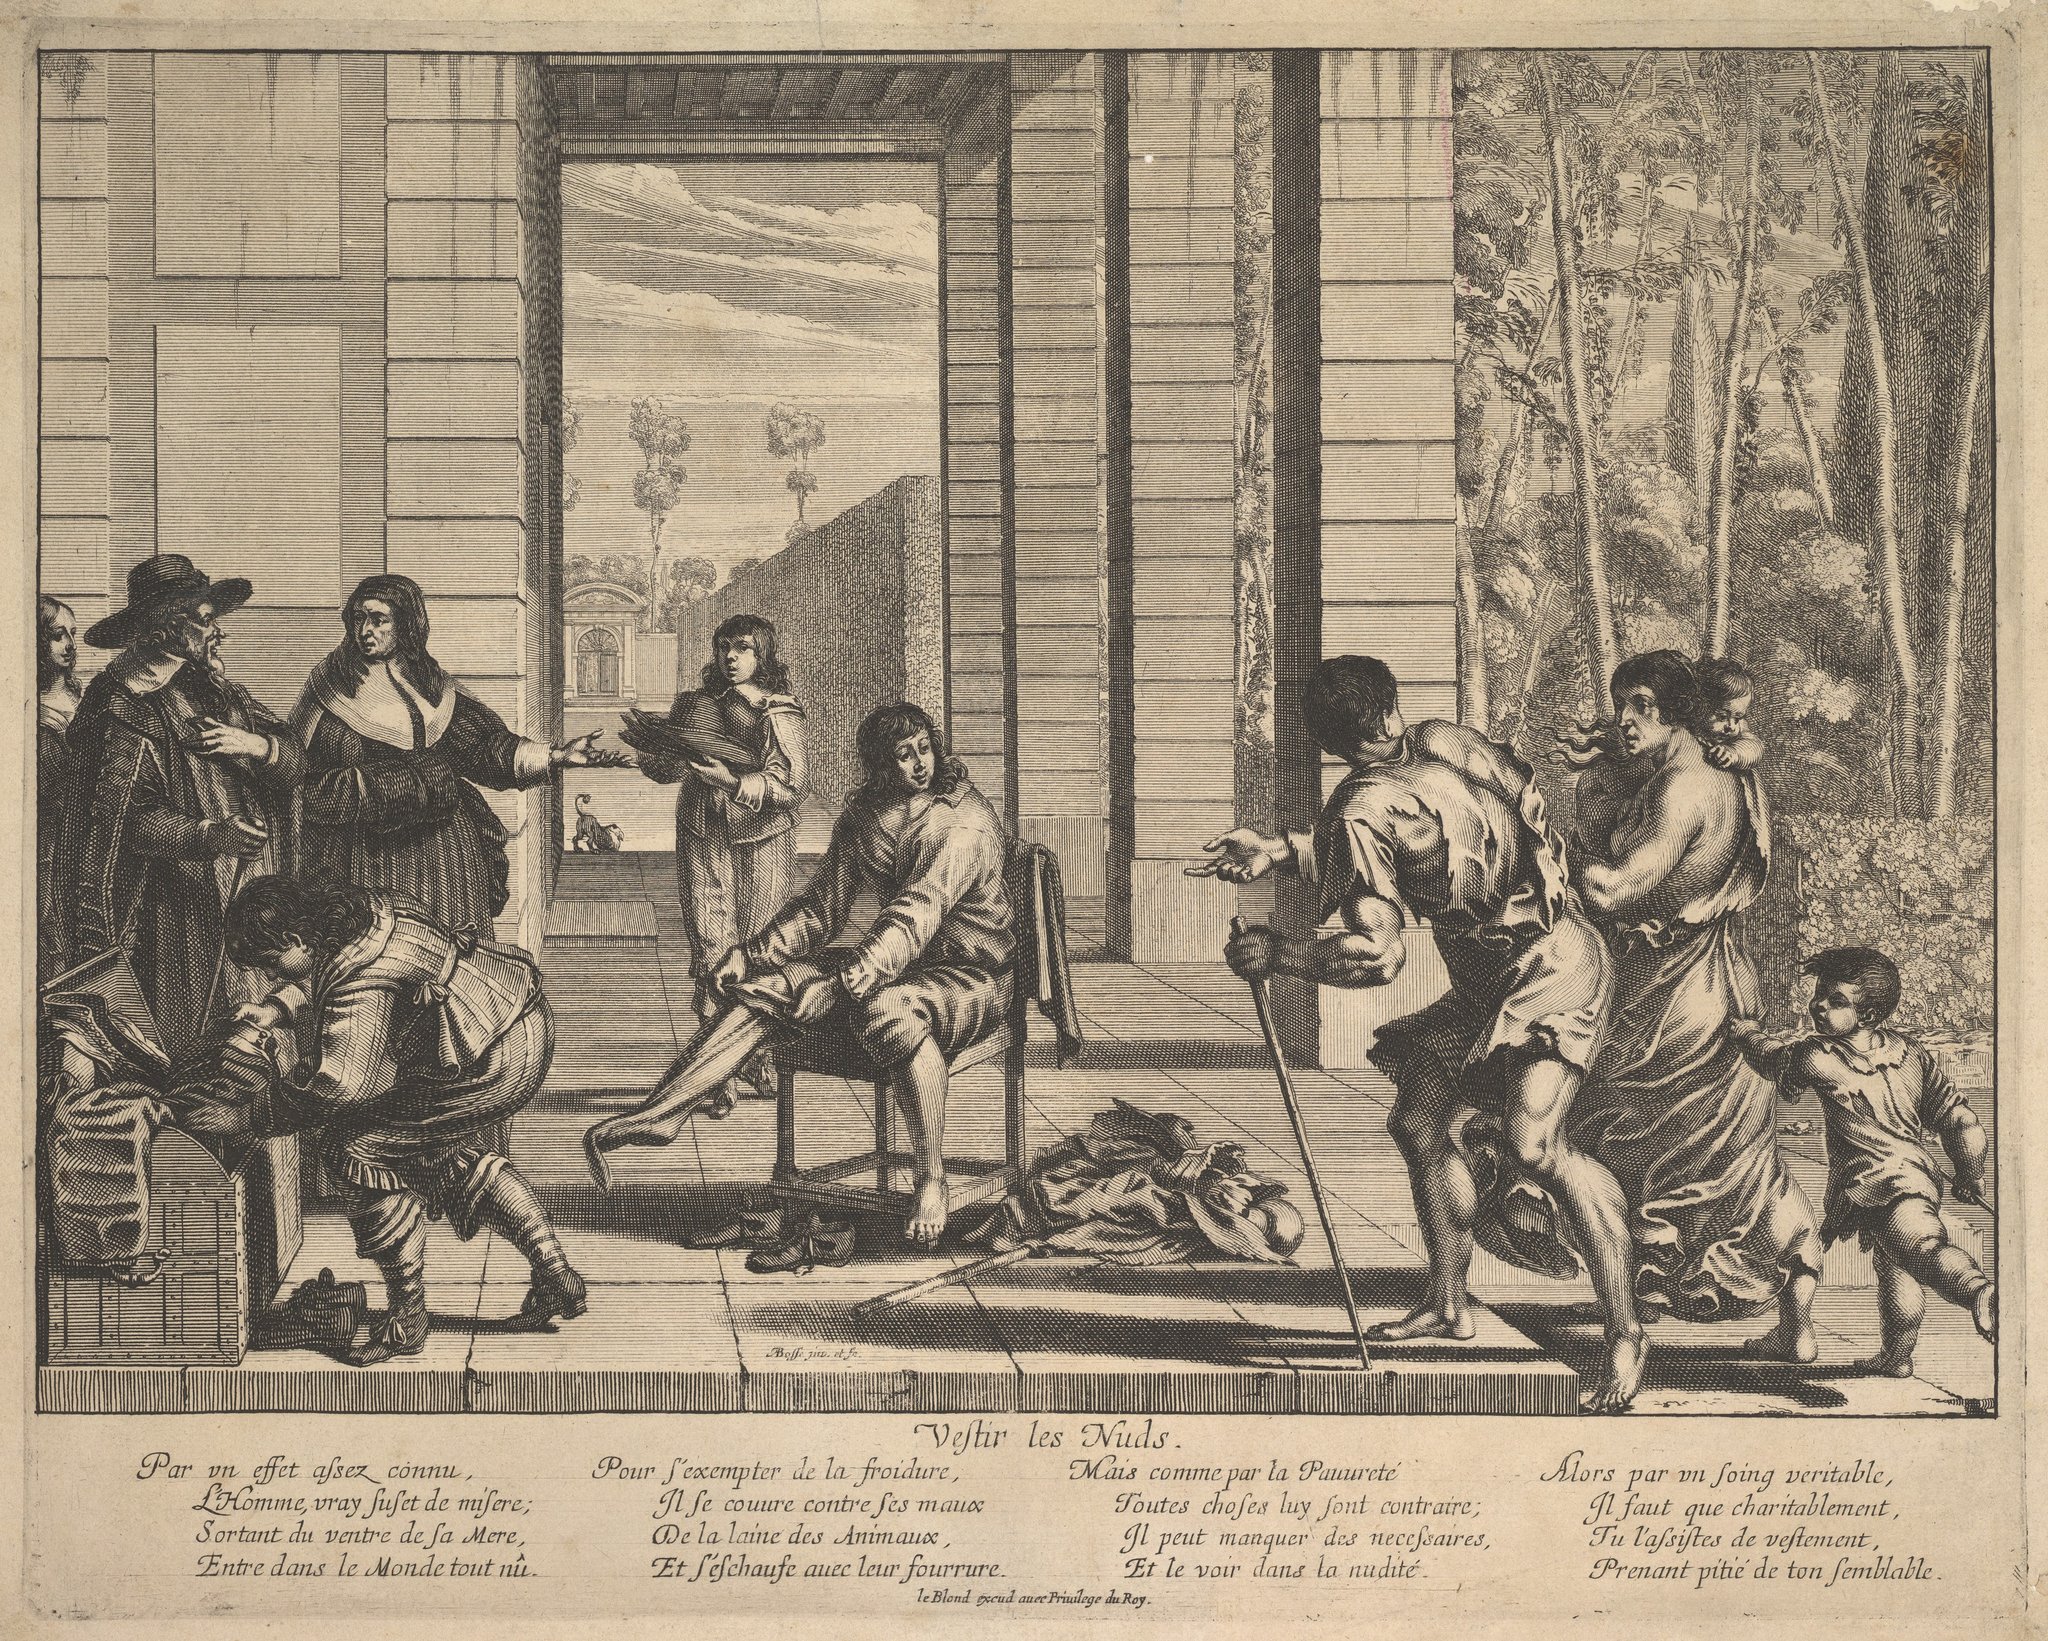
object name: print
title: Clothing Beggars, from "Acts of Mercy"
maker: abraham bosse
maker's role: artist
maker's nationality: french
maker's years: 1602-1676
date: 1635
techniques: etching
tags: infants,men,women,dressing